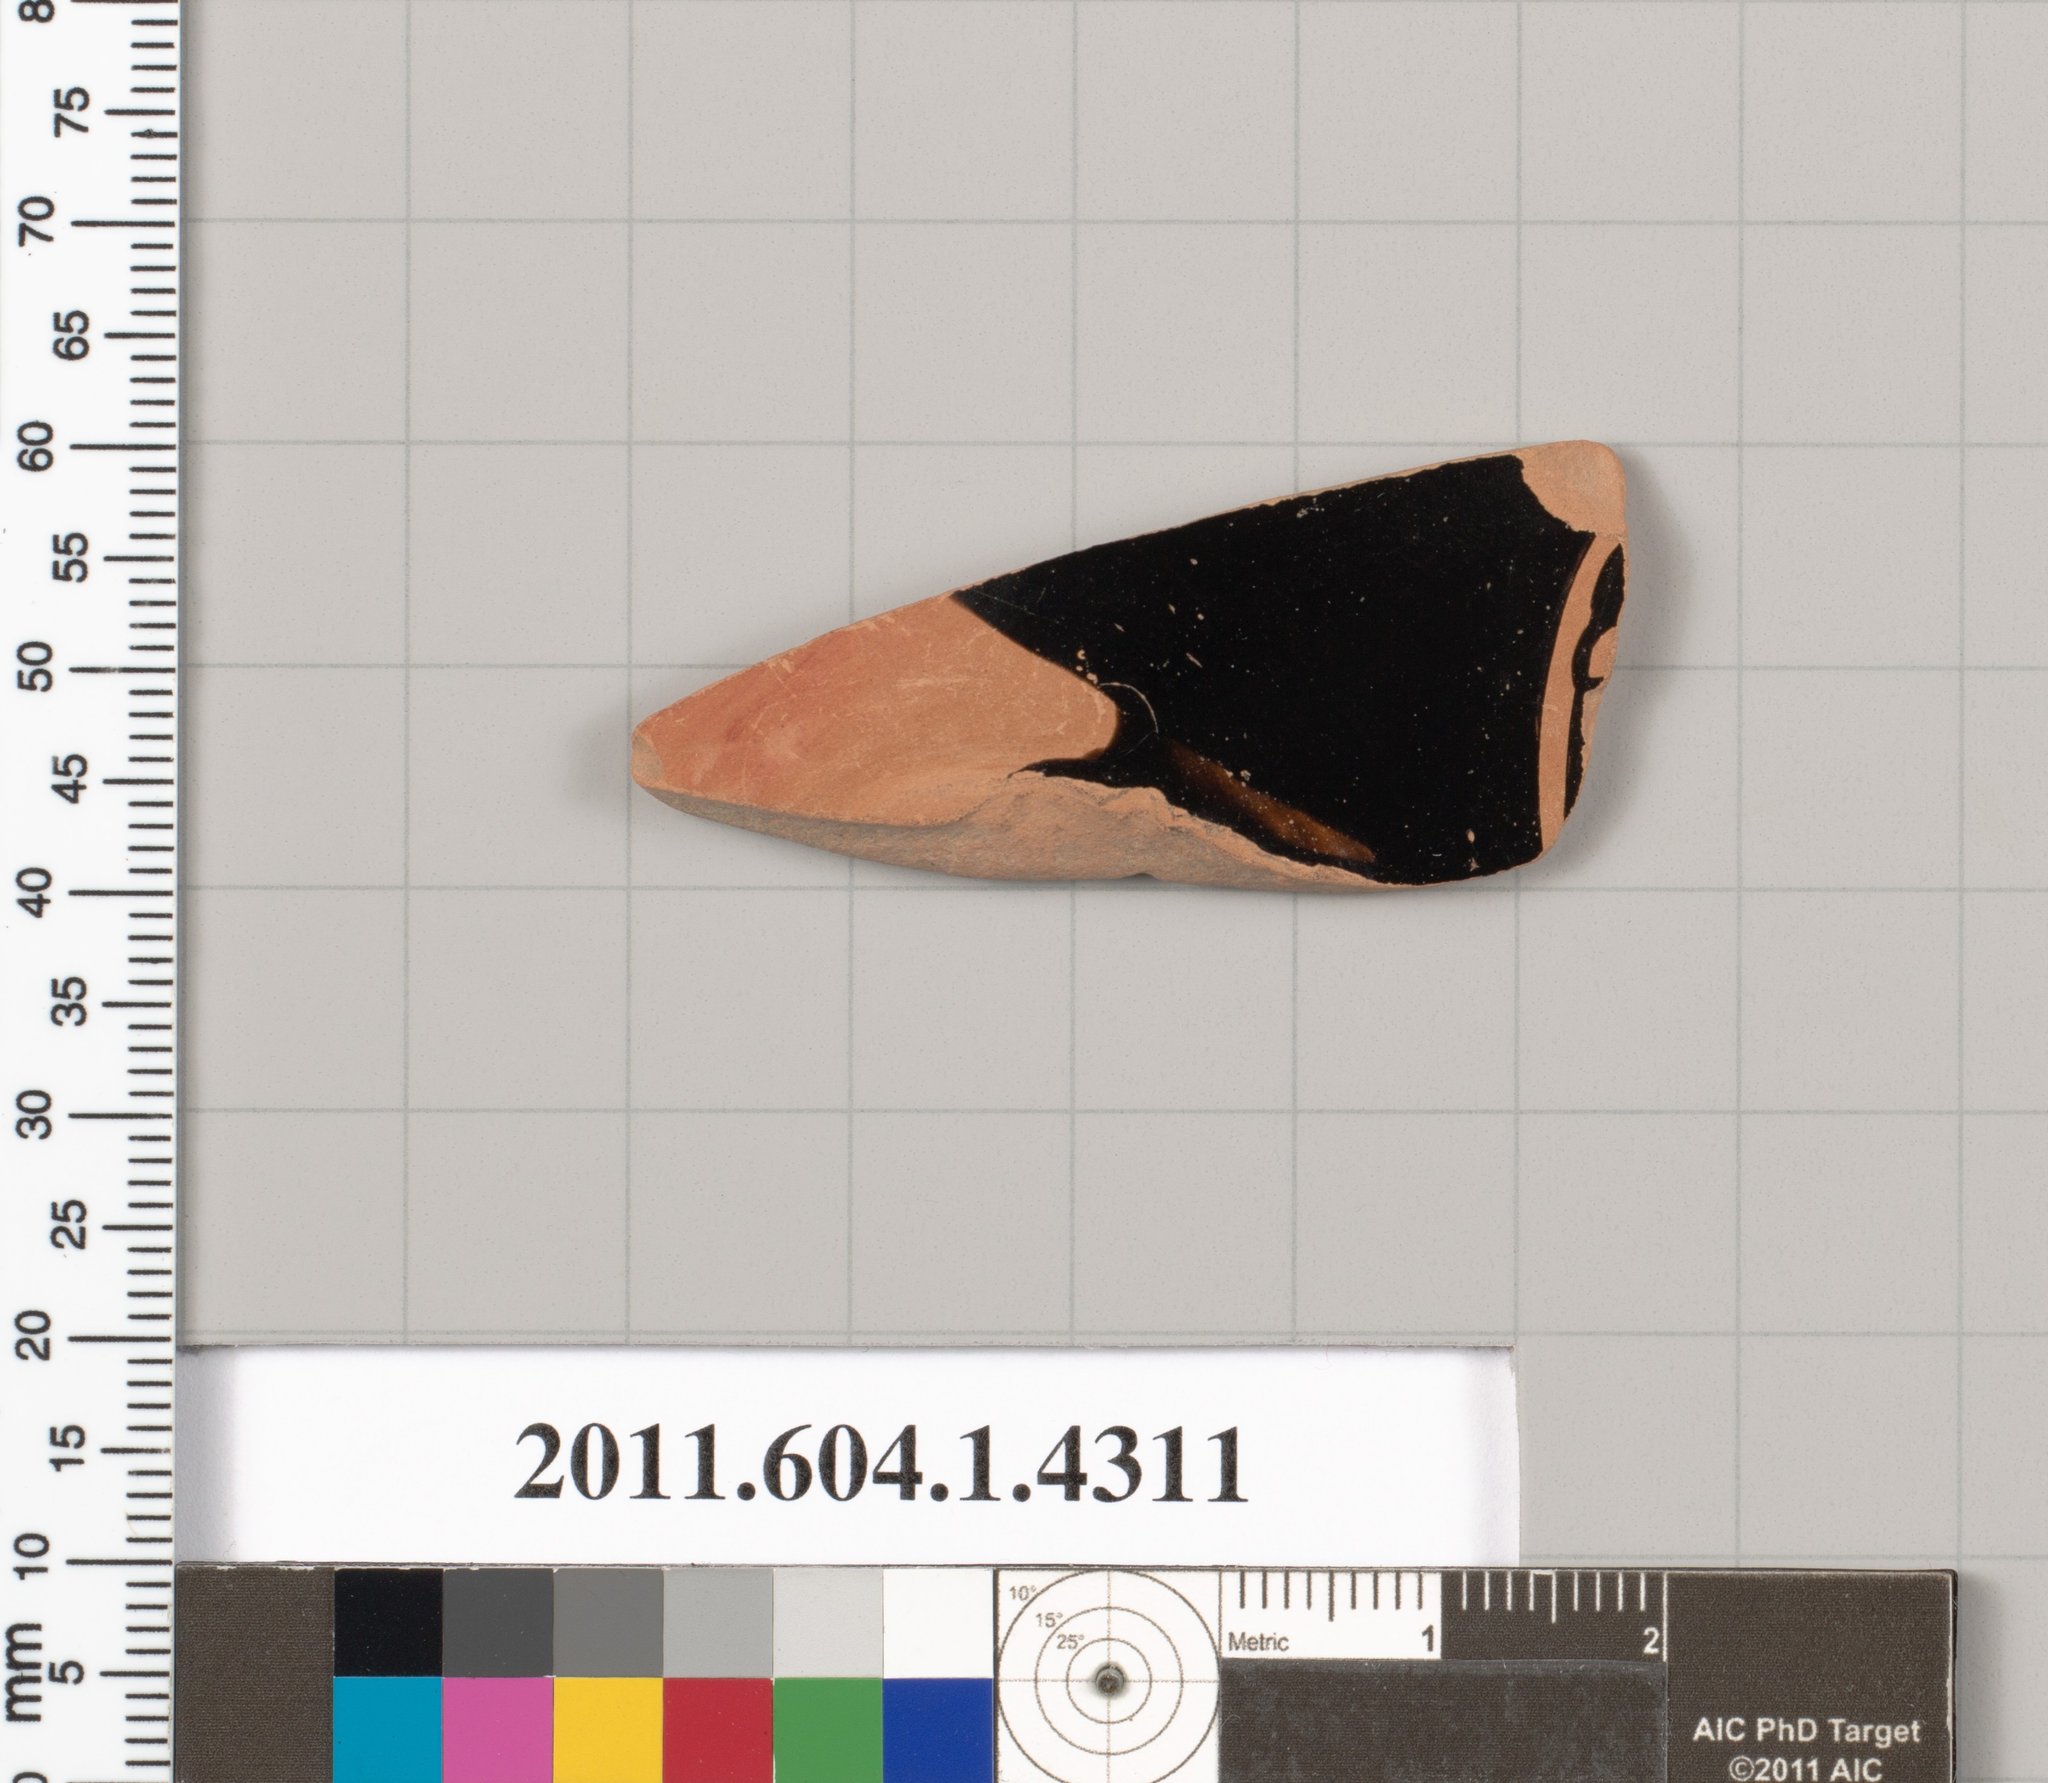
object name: kylix fragment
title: Terracotta fragment of a kylix (drinking cup)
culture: greek, attic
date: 500-451 BCE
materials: terracotta